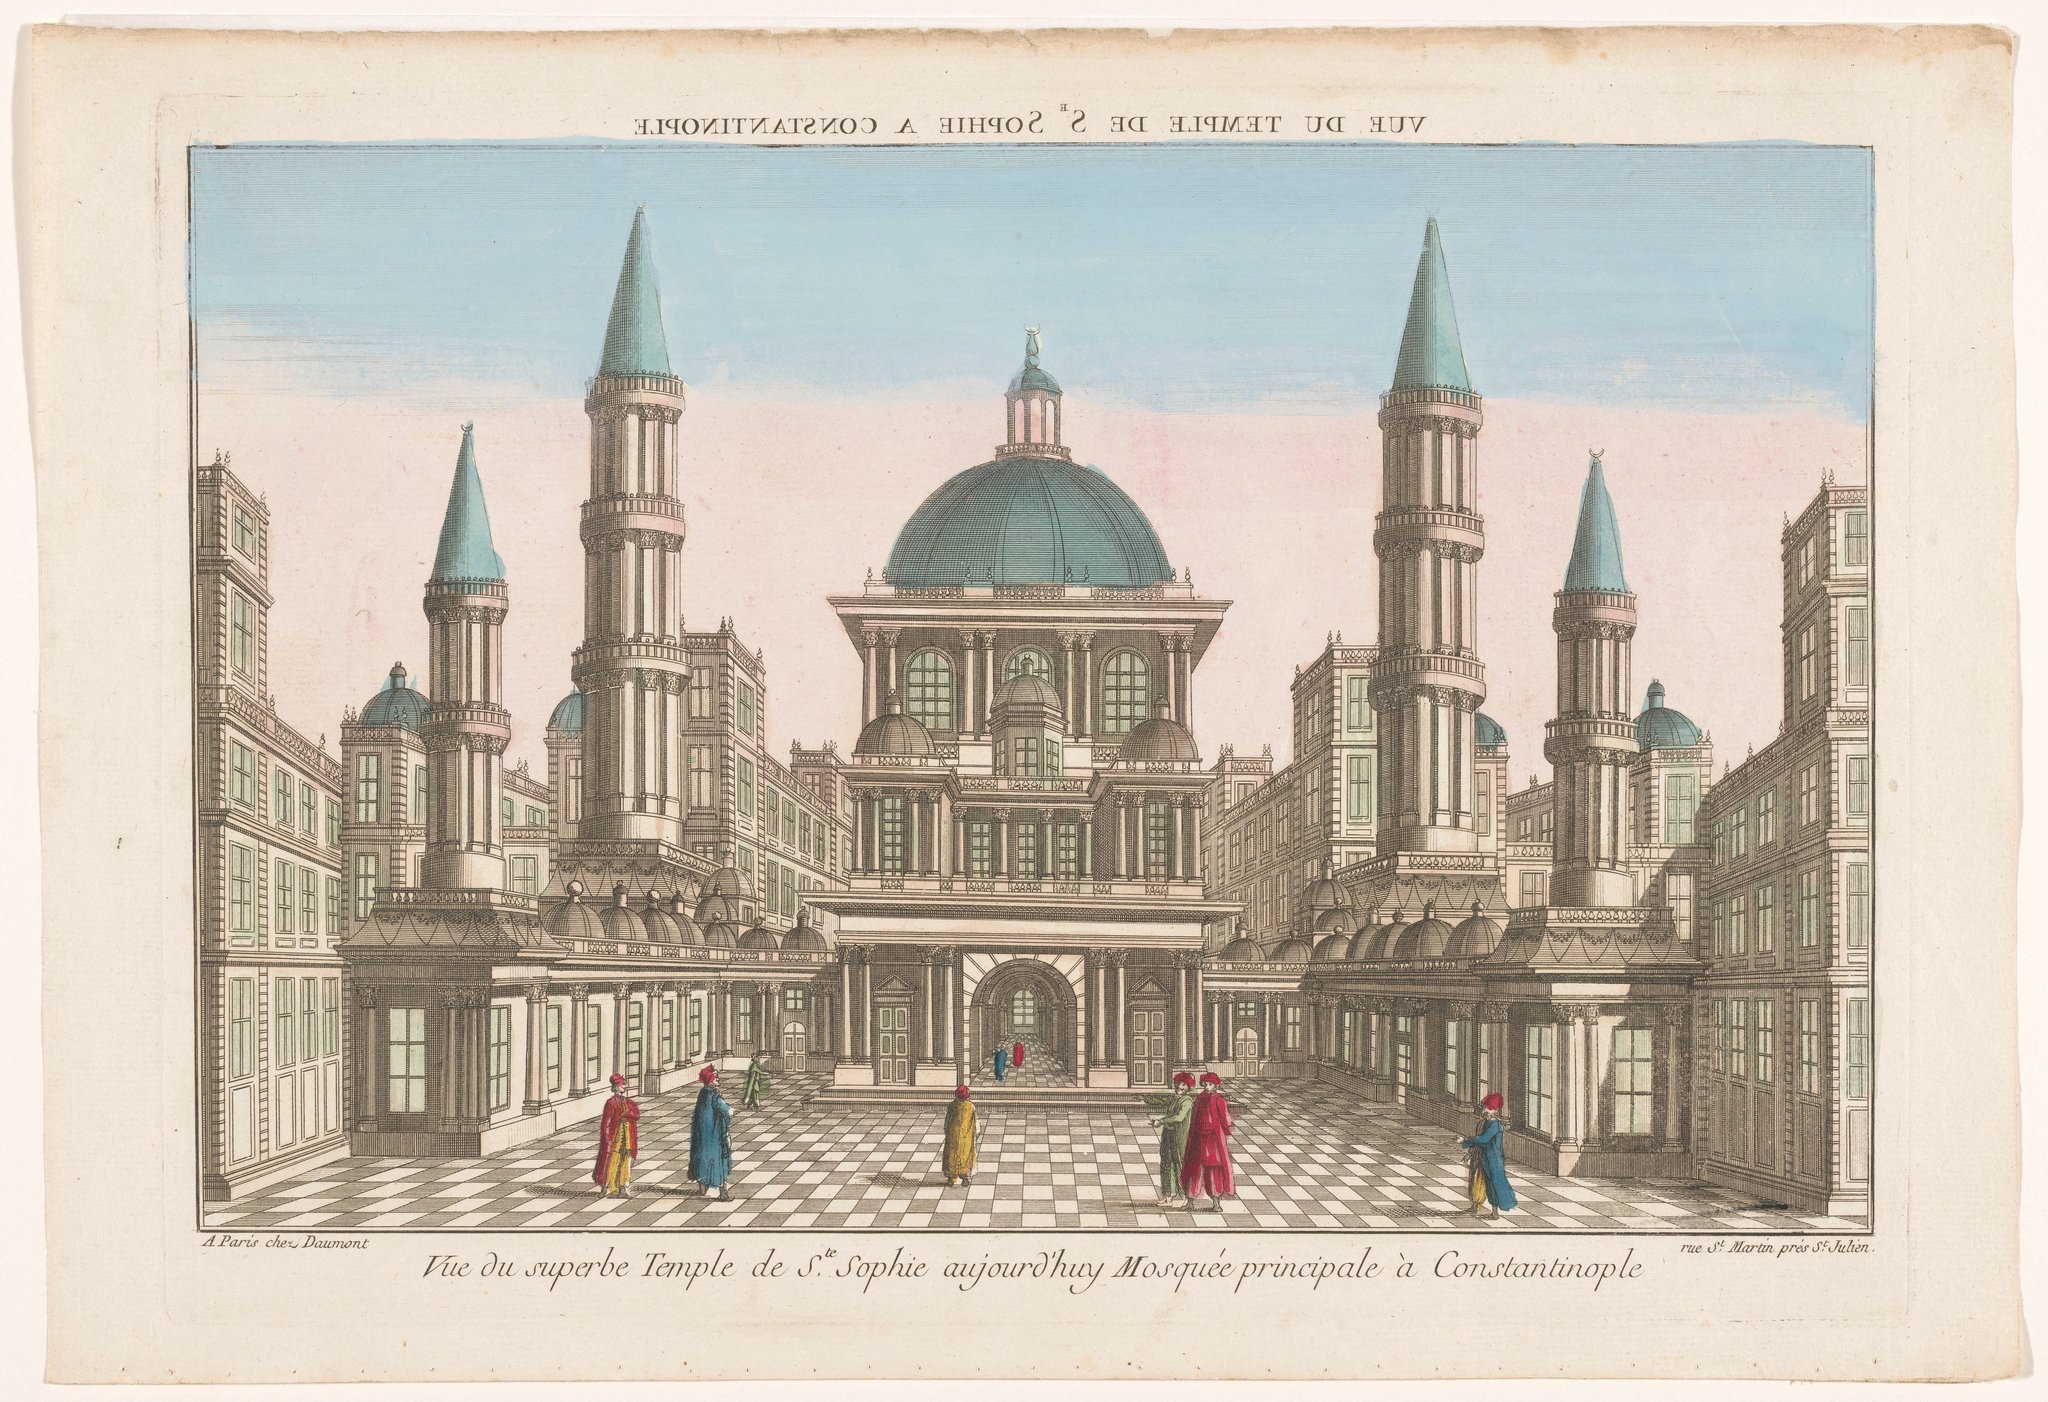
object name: opticaprent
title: Gezicht op de moskee Aya Sophia te Constantinopel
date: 1745-1775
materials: paper, watercolor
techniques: brush, etching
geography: paris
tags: temple, shrine ~ islam, mohammedanism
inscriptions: watermark, collector's mark: Lugt 2166